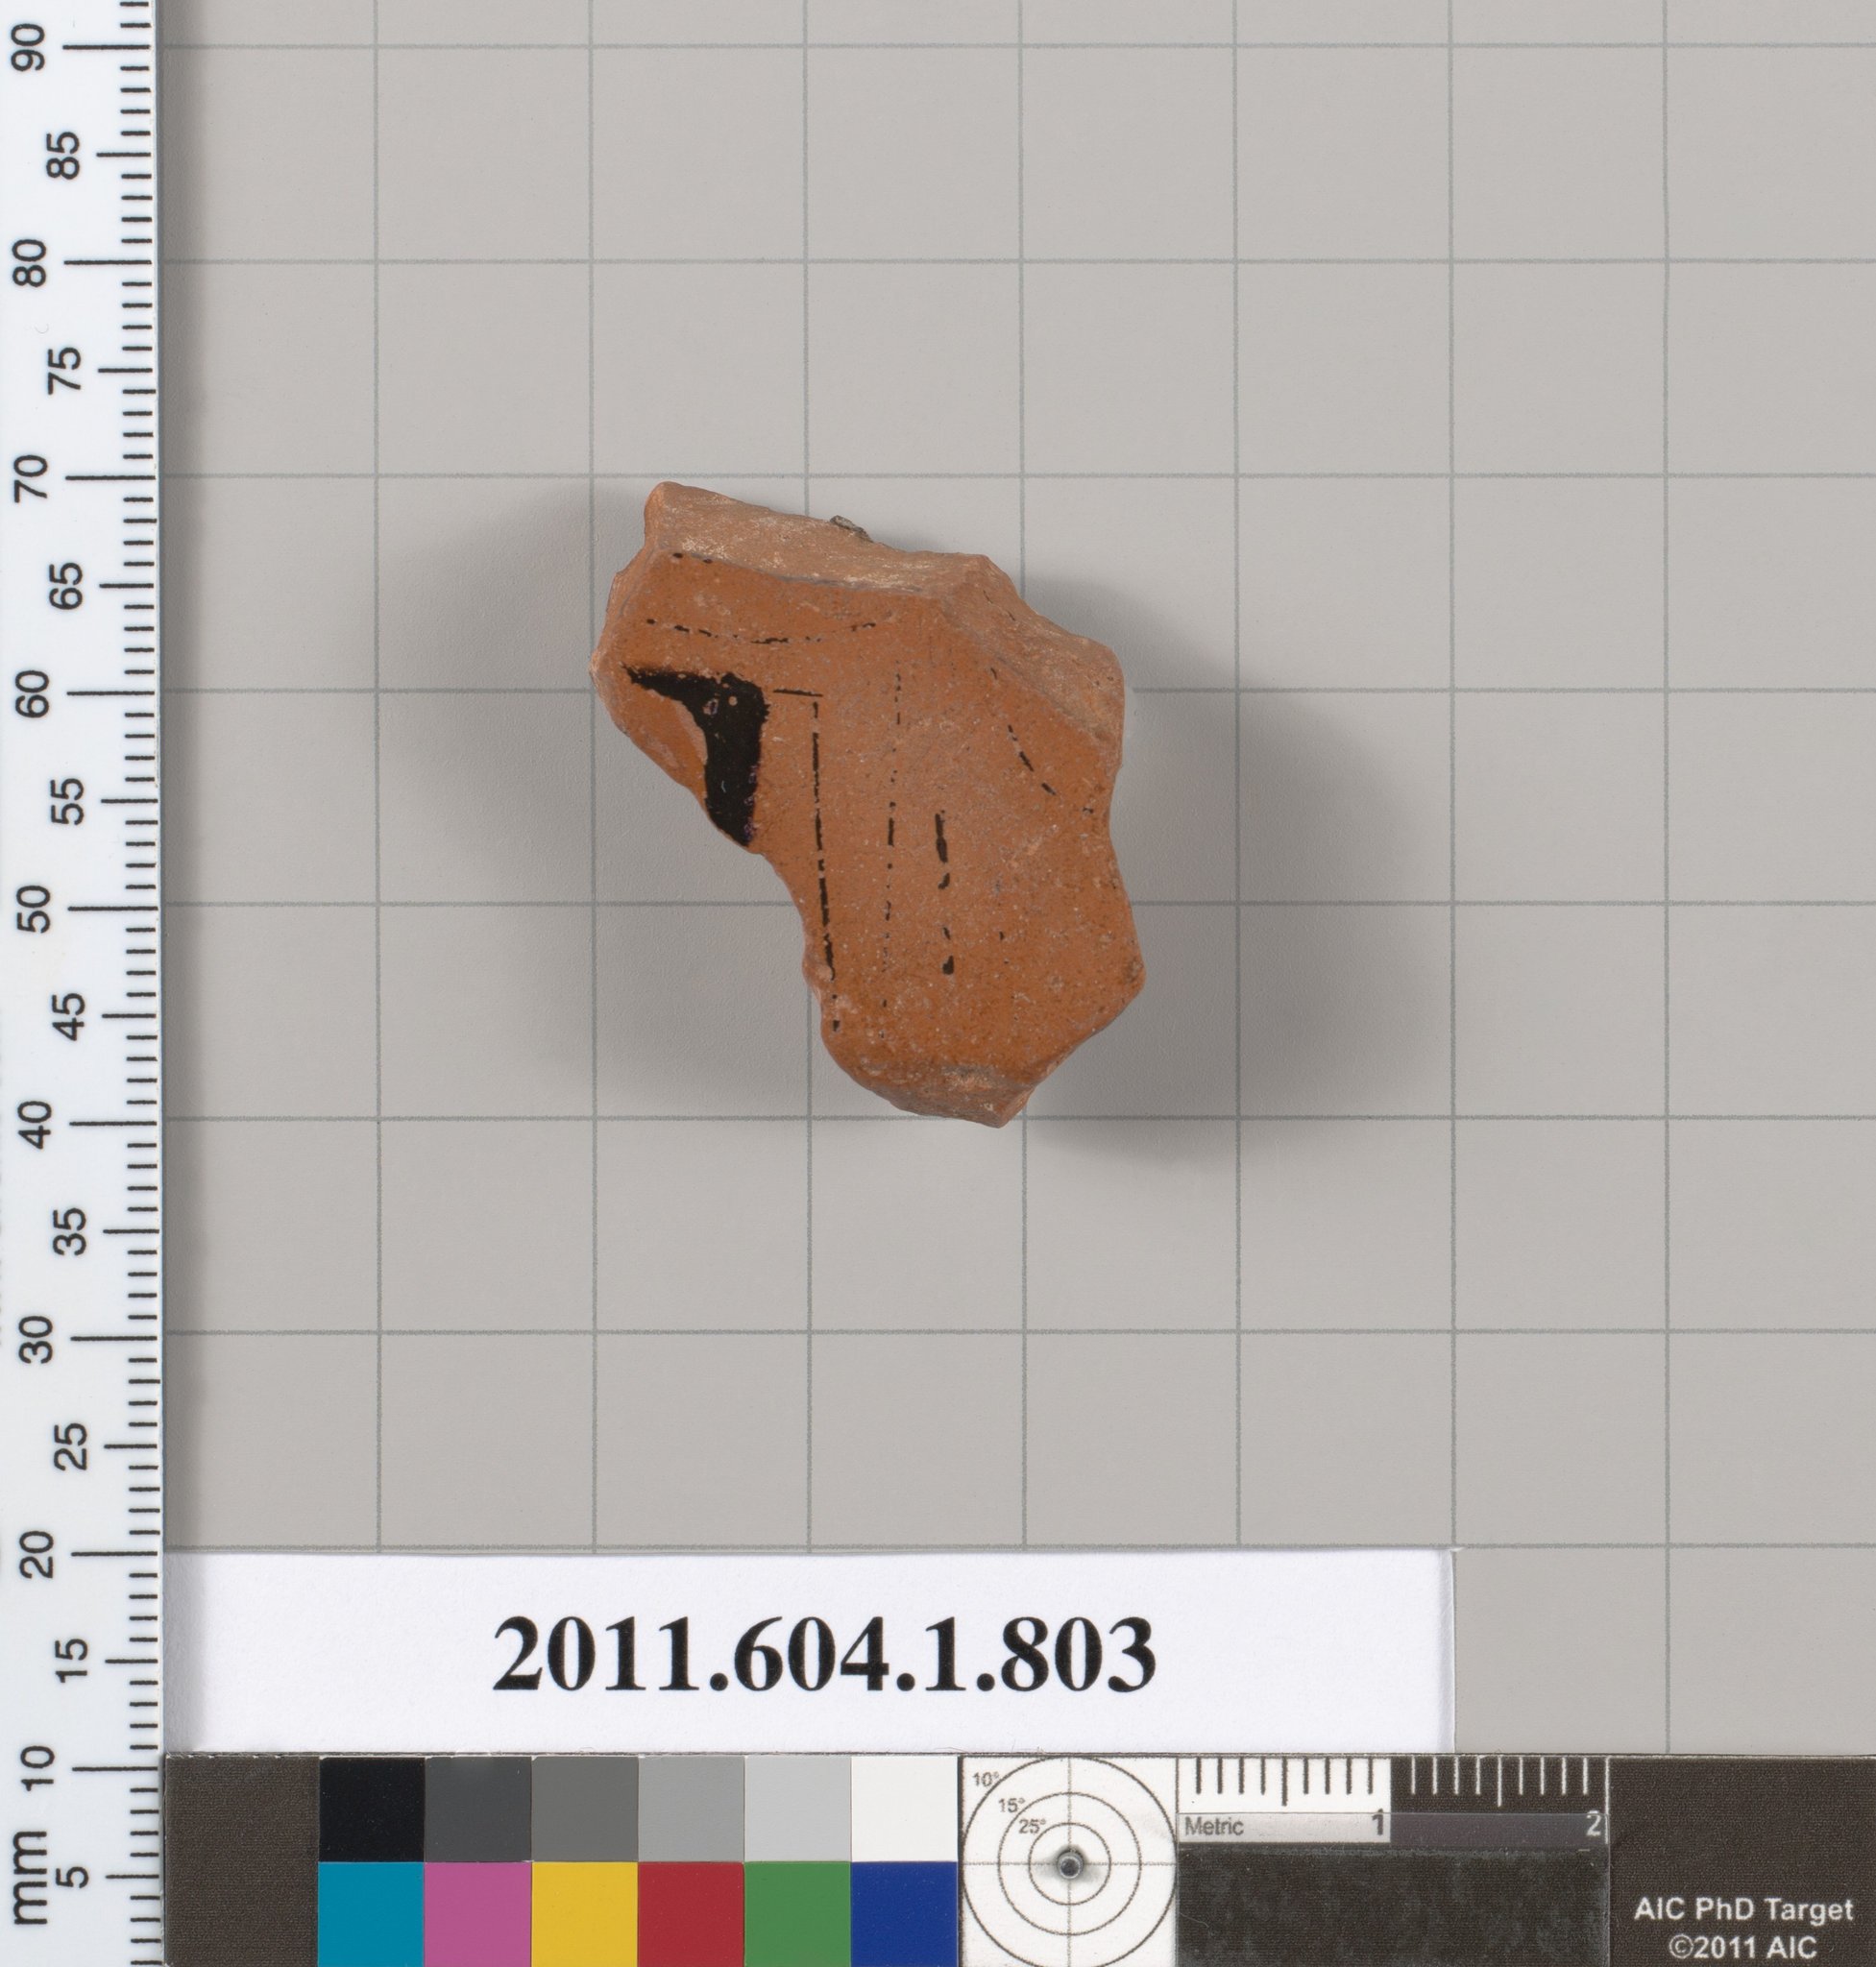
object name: kylix fragment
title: Terracotta fragment of a kylix (drinking cup)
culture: greek, attic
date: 475-451 BCE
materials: terracotta